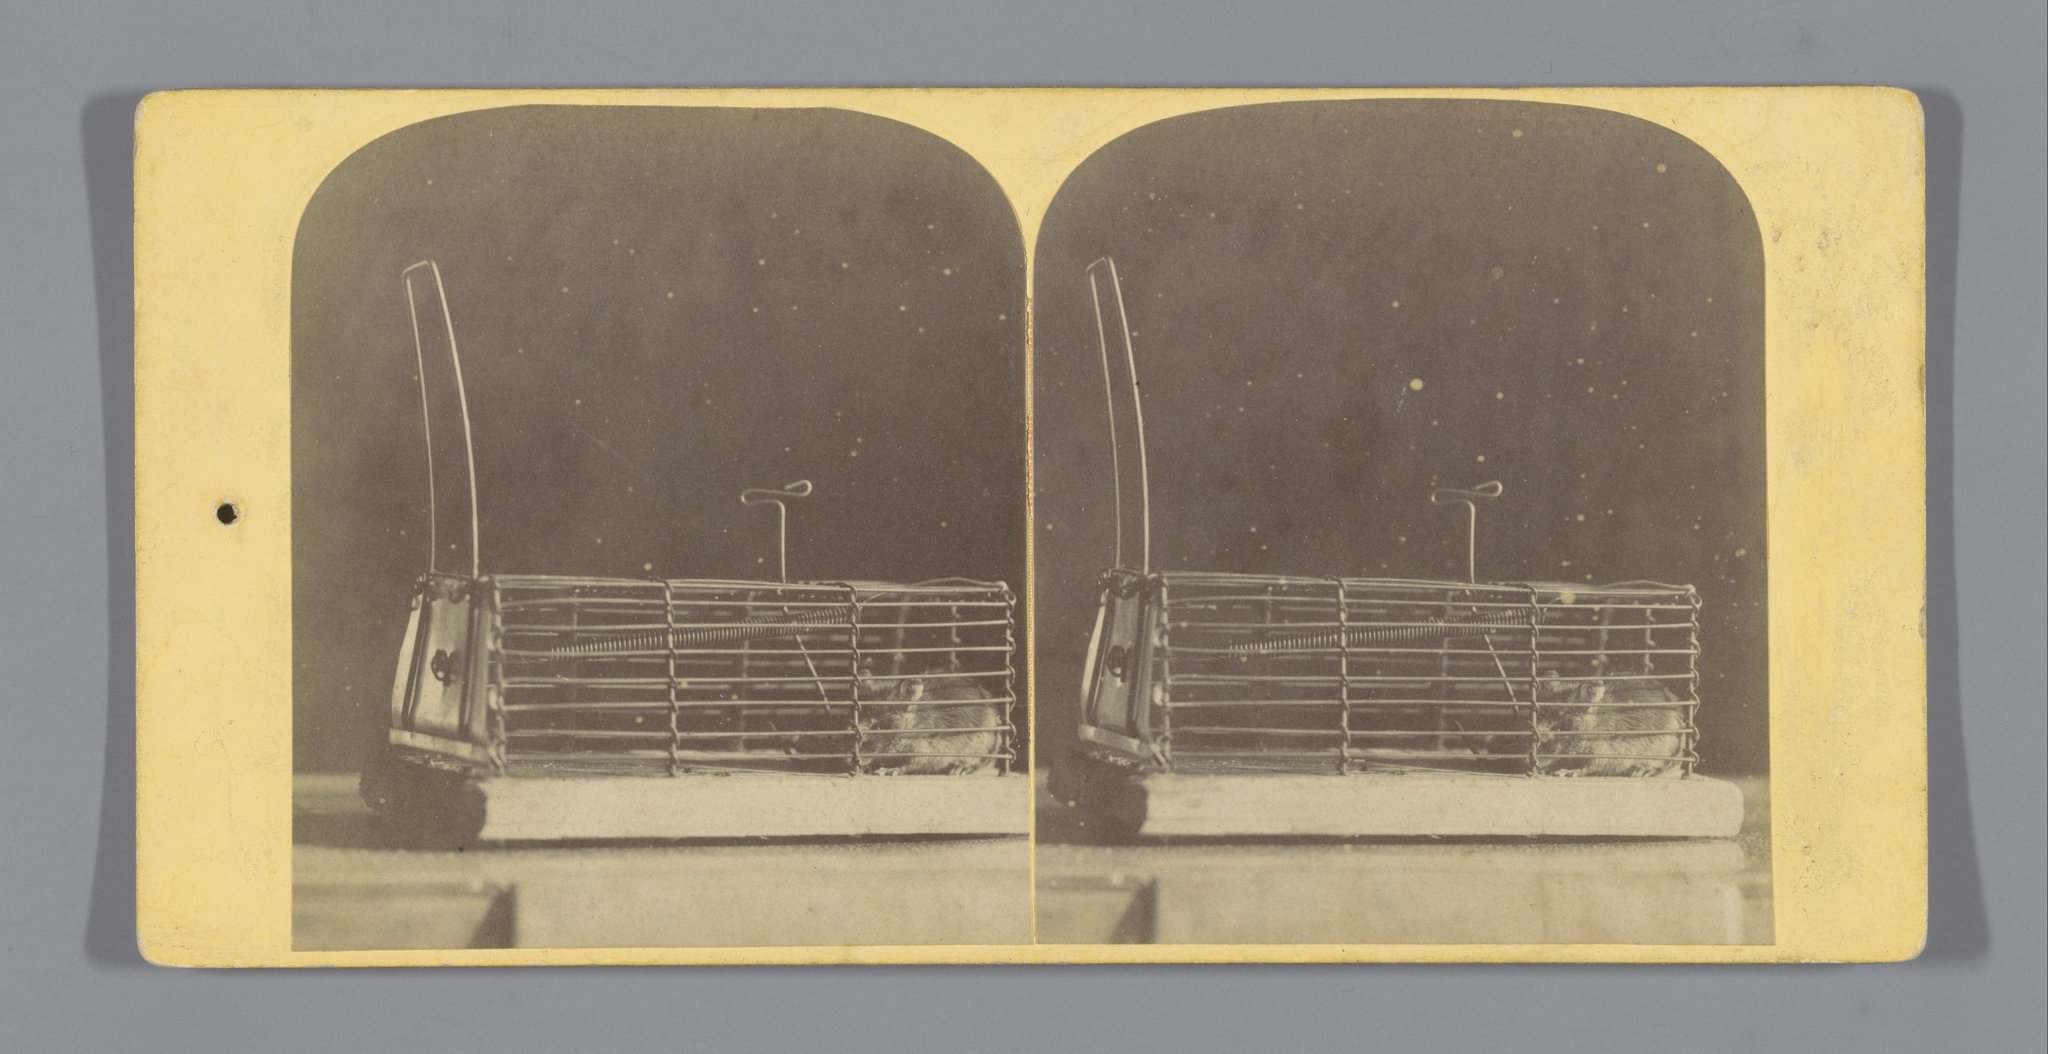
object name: stereograph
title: Muizenval met een muis erin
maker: Anonymous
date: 1850-1880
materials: cardboard, photographic support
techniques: albumen print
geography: europe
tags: mouse trap, europe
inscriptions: inscription: ‘Muizenval’